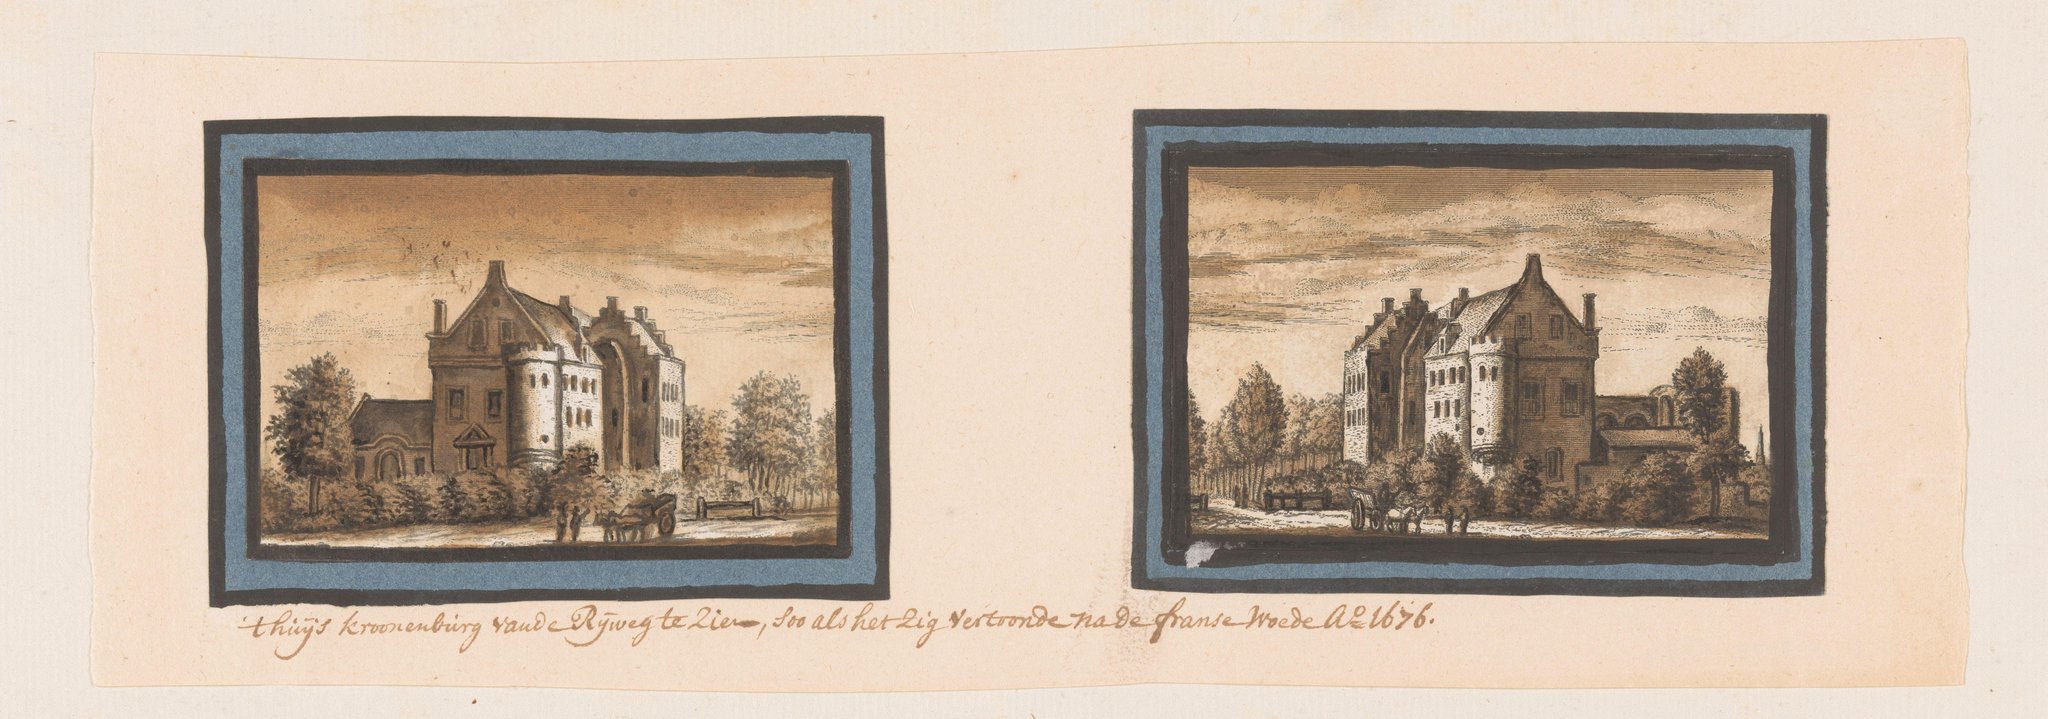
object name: drawing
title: Gezichten op Huis Kronenburg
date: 1725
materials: ink, paper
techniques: brush, etching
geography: amsterdam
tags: castle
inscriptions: inscription: ‘'t Huijs Kroonenburg van de Rijweg te zien, soo als het zig vertoonde na de Franse woede Ao. 1676’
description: Prent uit: Rademaker, Abraham. Kabinet van Nederlandsche outheden en gezichten: vervat in 300 konstplaten. Amsterdam: Willem Barents, 1725.